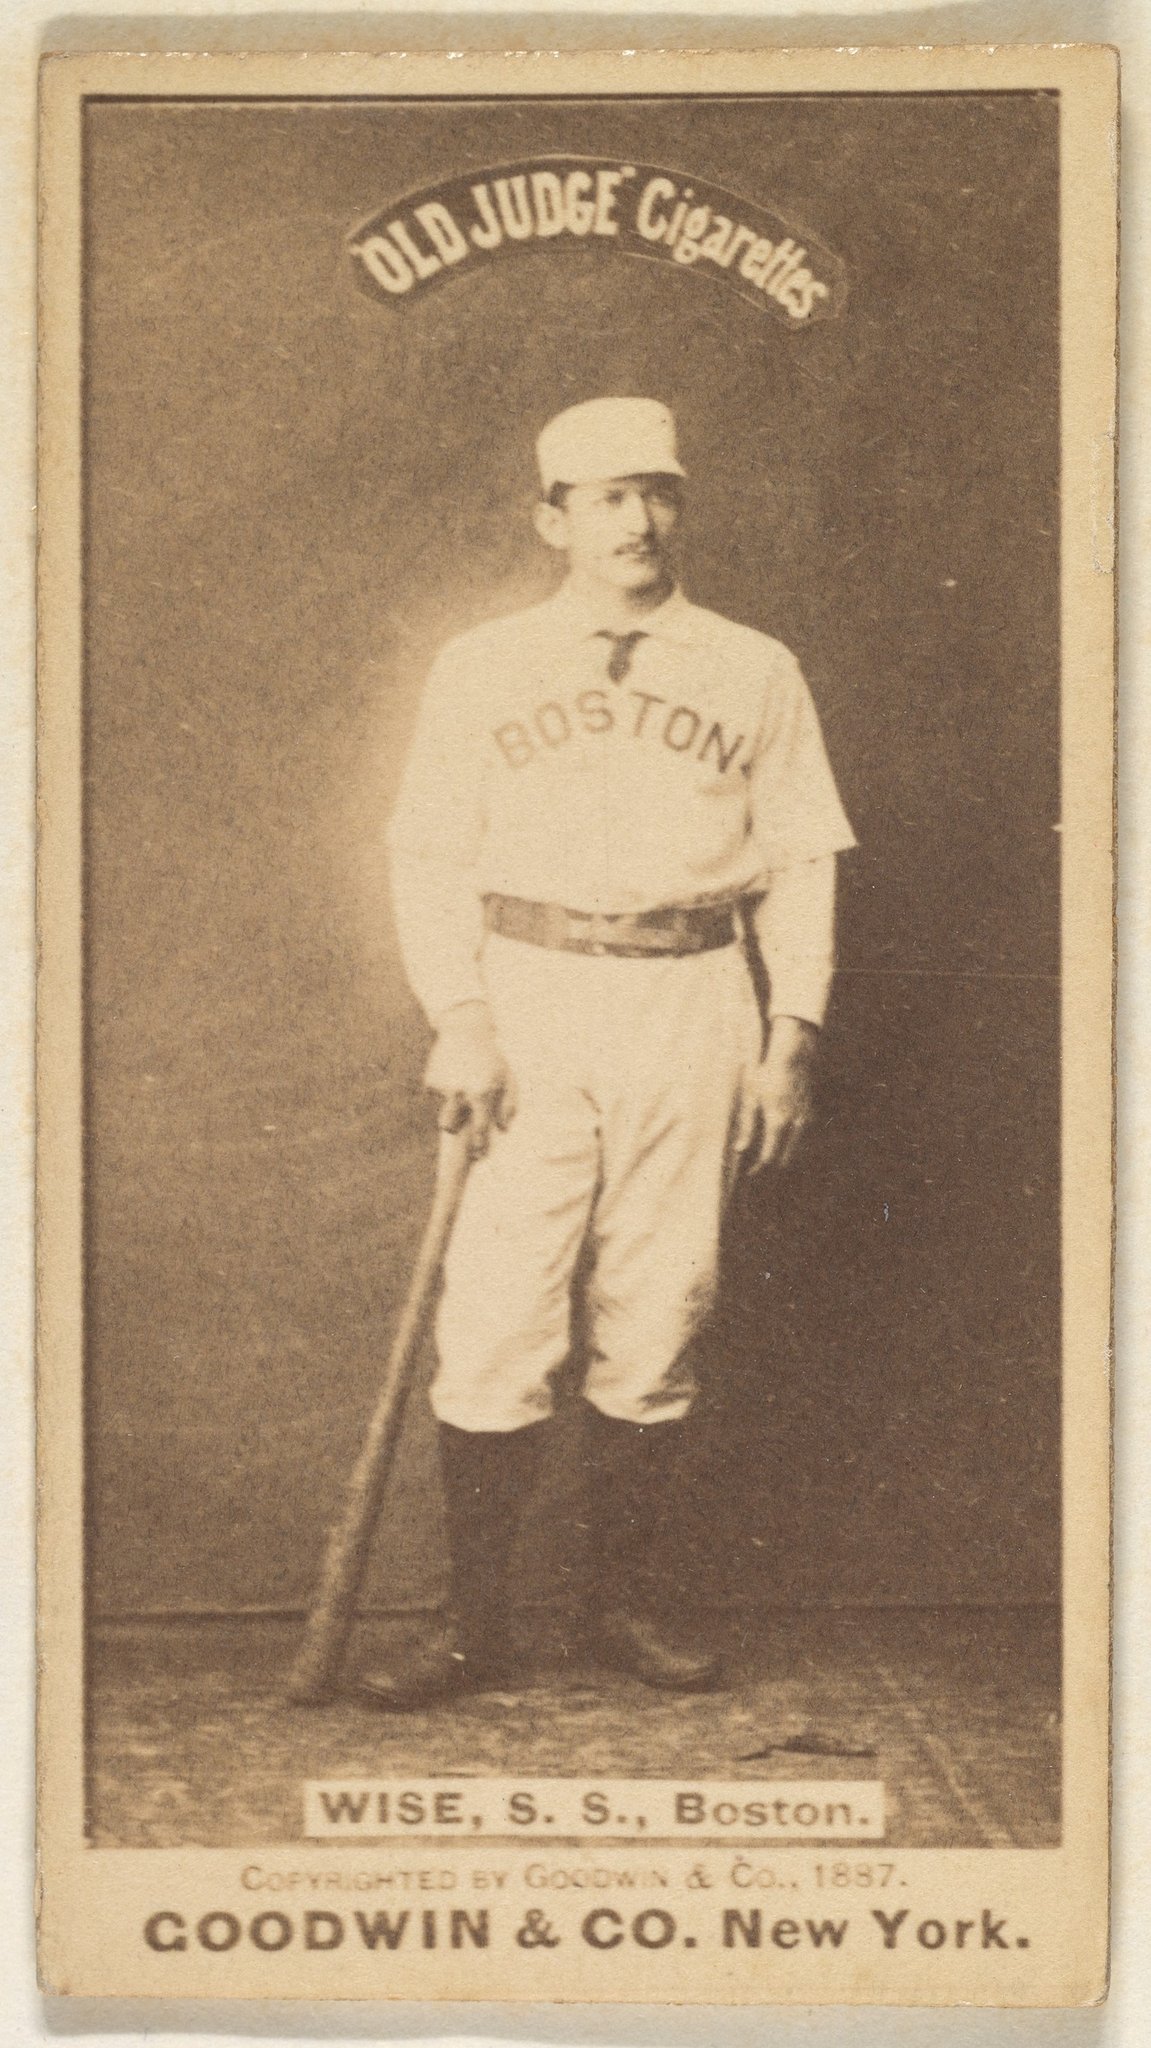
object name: baseball card, photograph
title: Wise, Shortstop, Boston, from the Old Judge series (N172) for Old Judge Cigarettes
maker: goodwin & company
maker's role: publisher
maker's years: 1850-1950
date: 1887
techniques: albumen silver print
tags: men,portraits,baseball,athletes